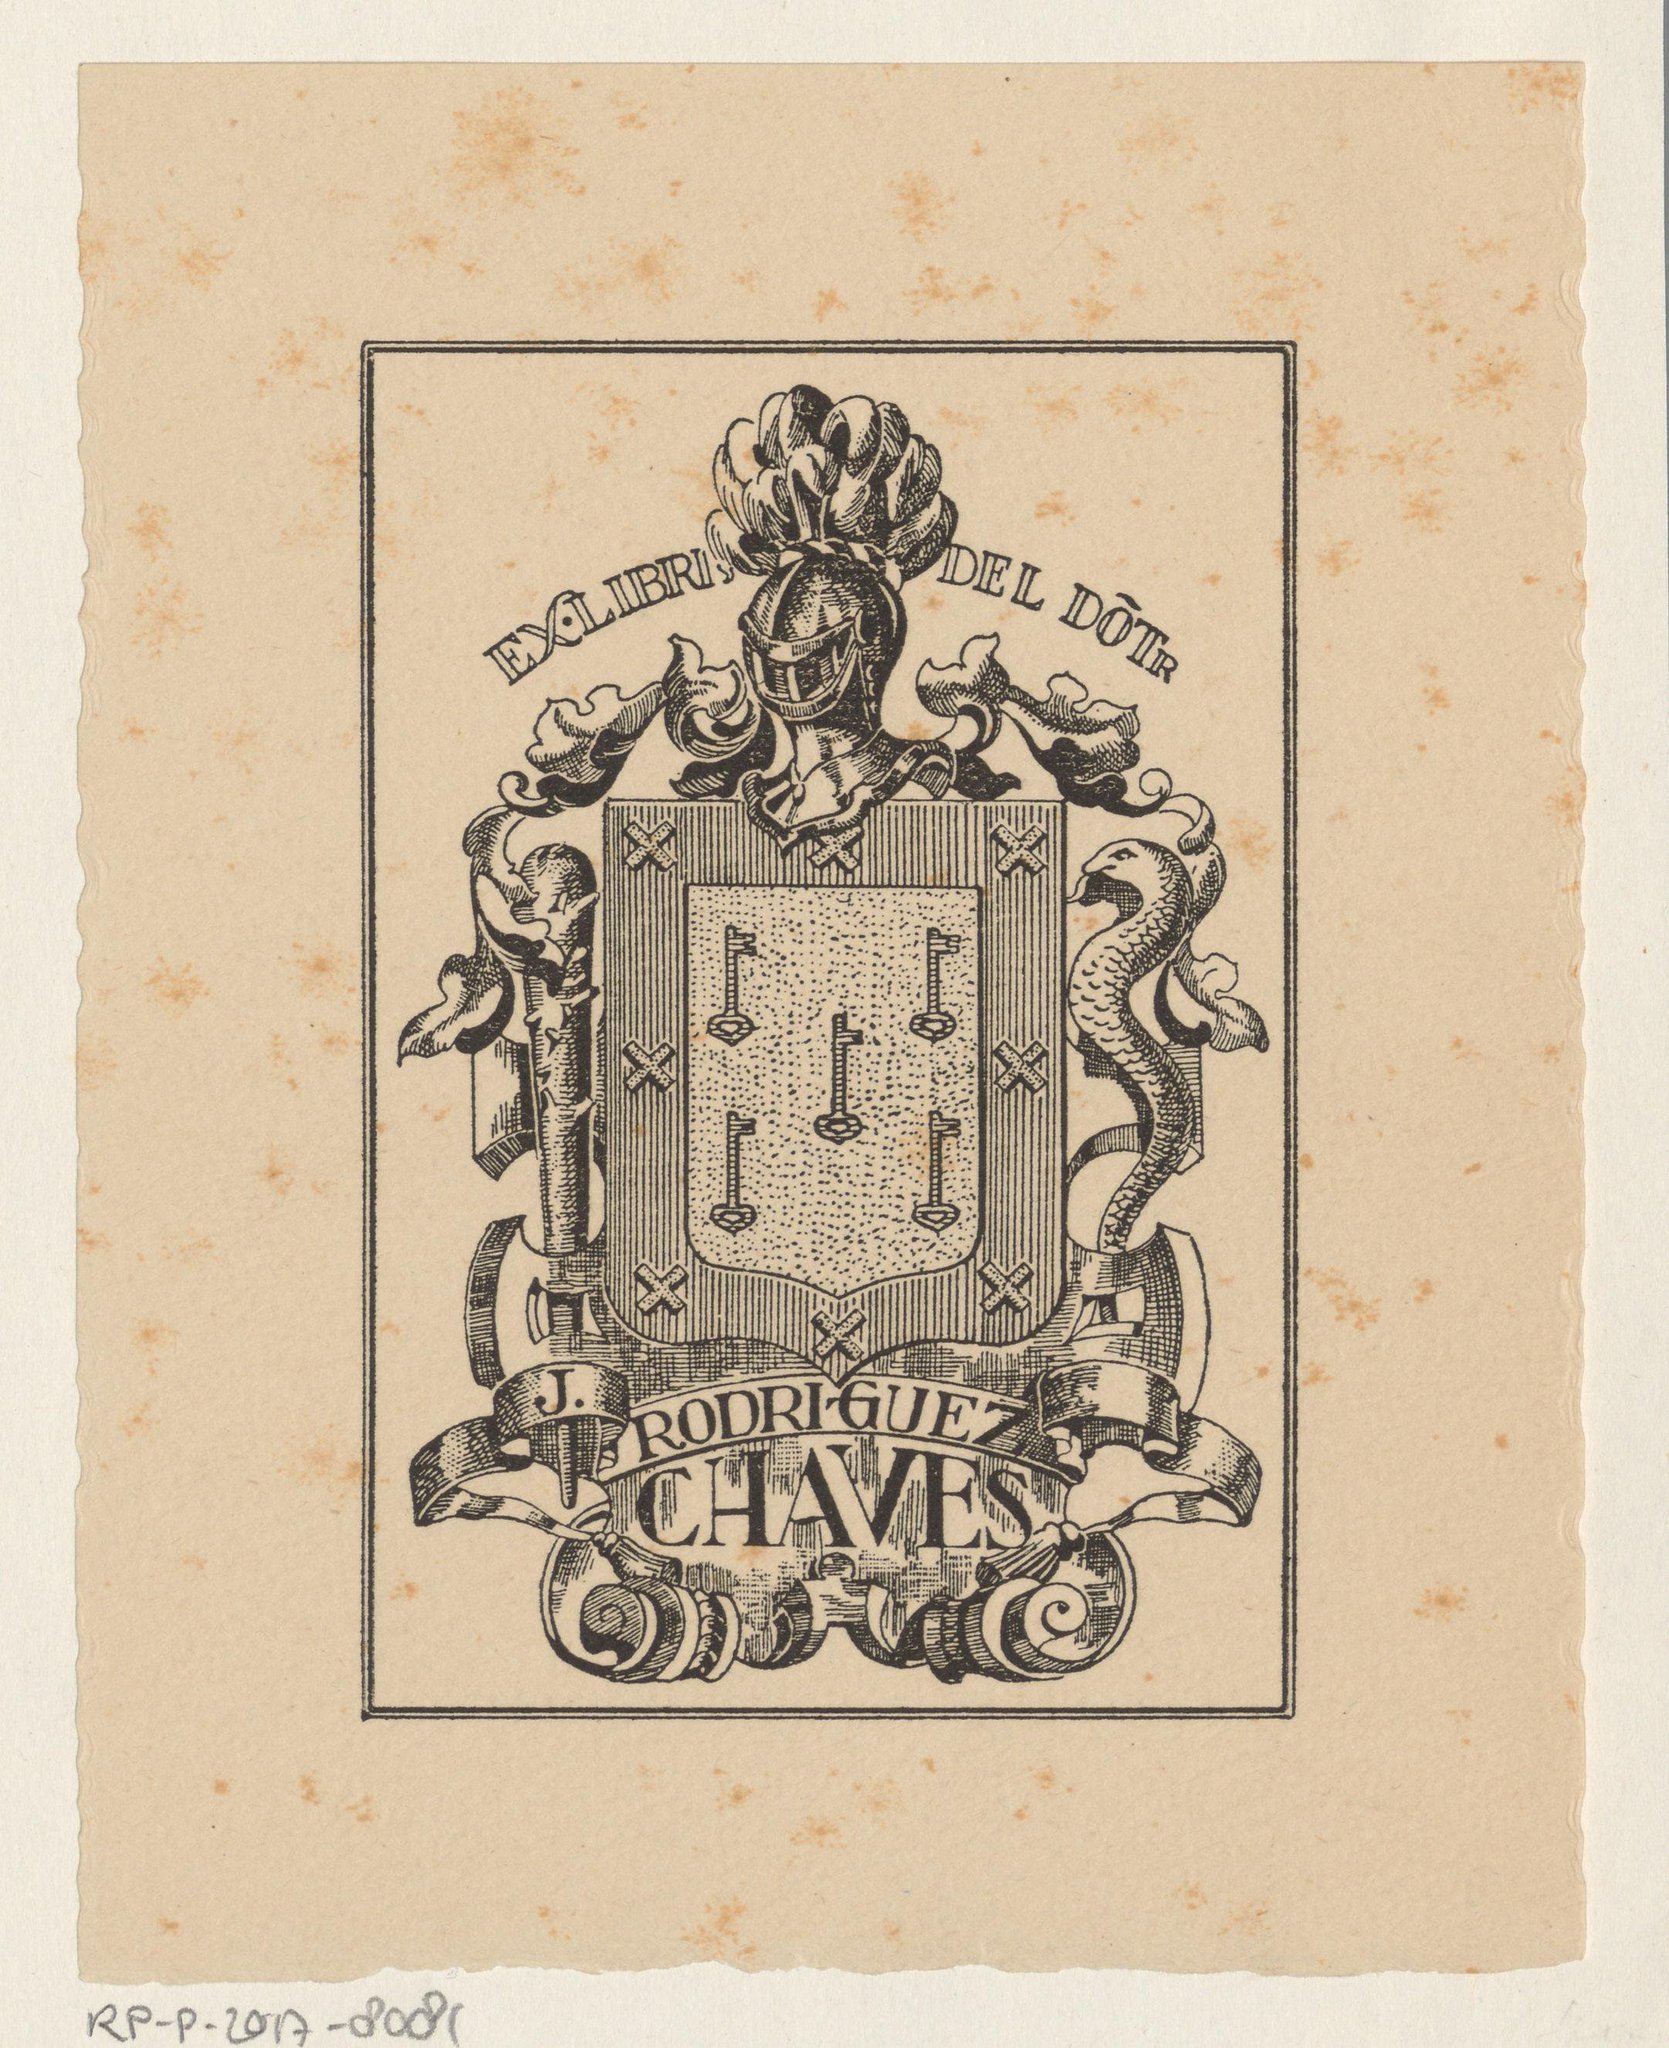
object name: bookplate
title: Ex libris del Dotr J. Rodriguez Chaves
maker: Anonymous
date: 1900-1999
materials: paper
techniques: printing block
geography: spain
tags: josé rodriguez chaves, key, armorial bearing, heraldry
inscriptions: stamp: ‘Dr. J.R. Chaves/ Artés, 34/ Igualada/ (Barcelona) España’